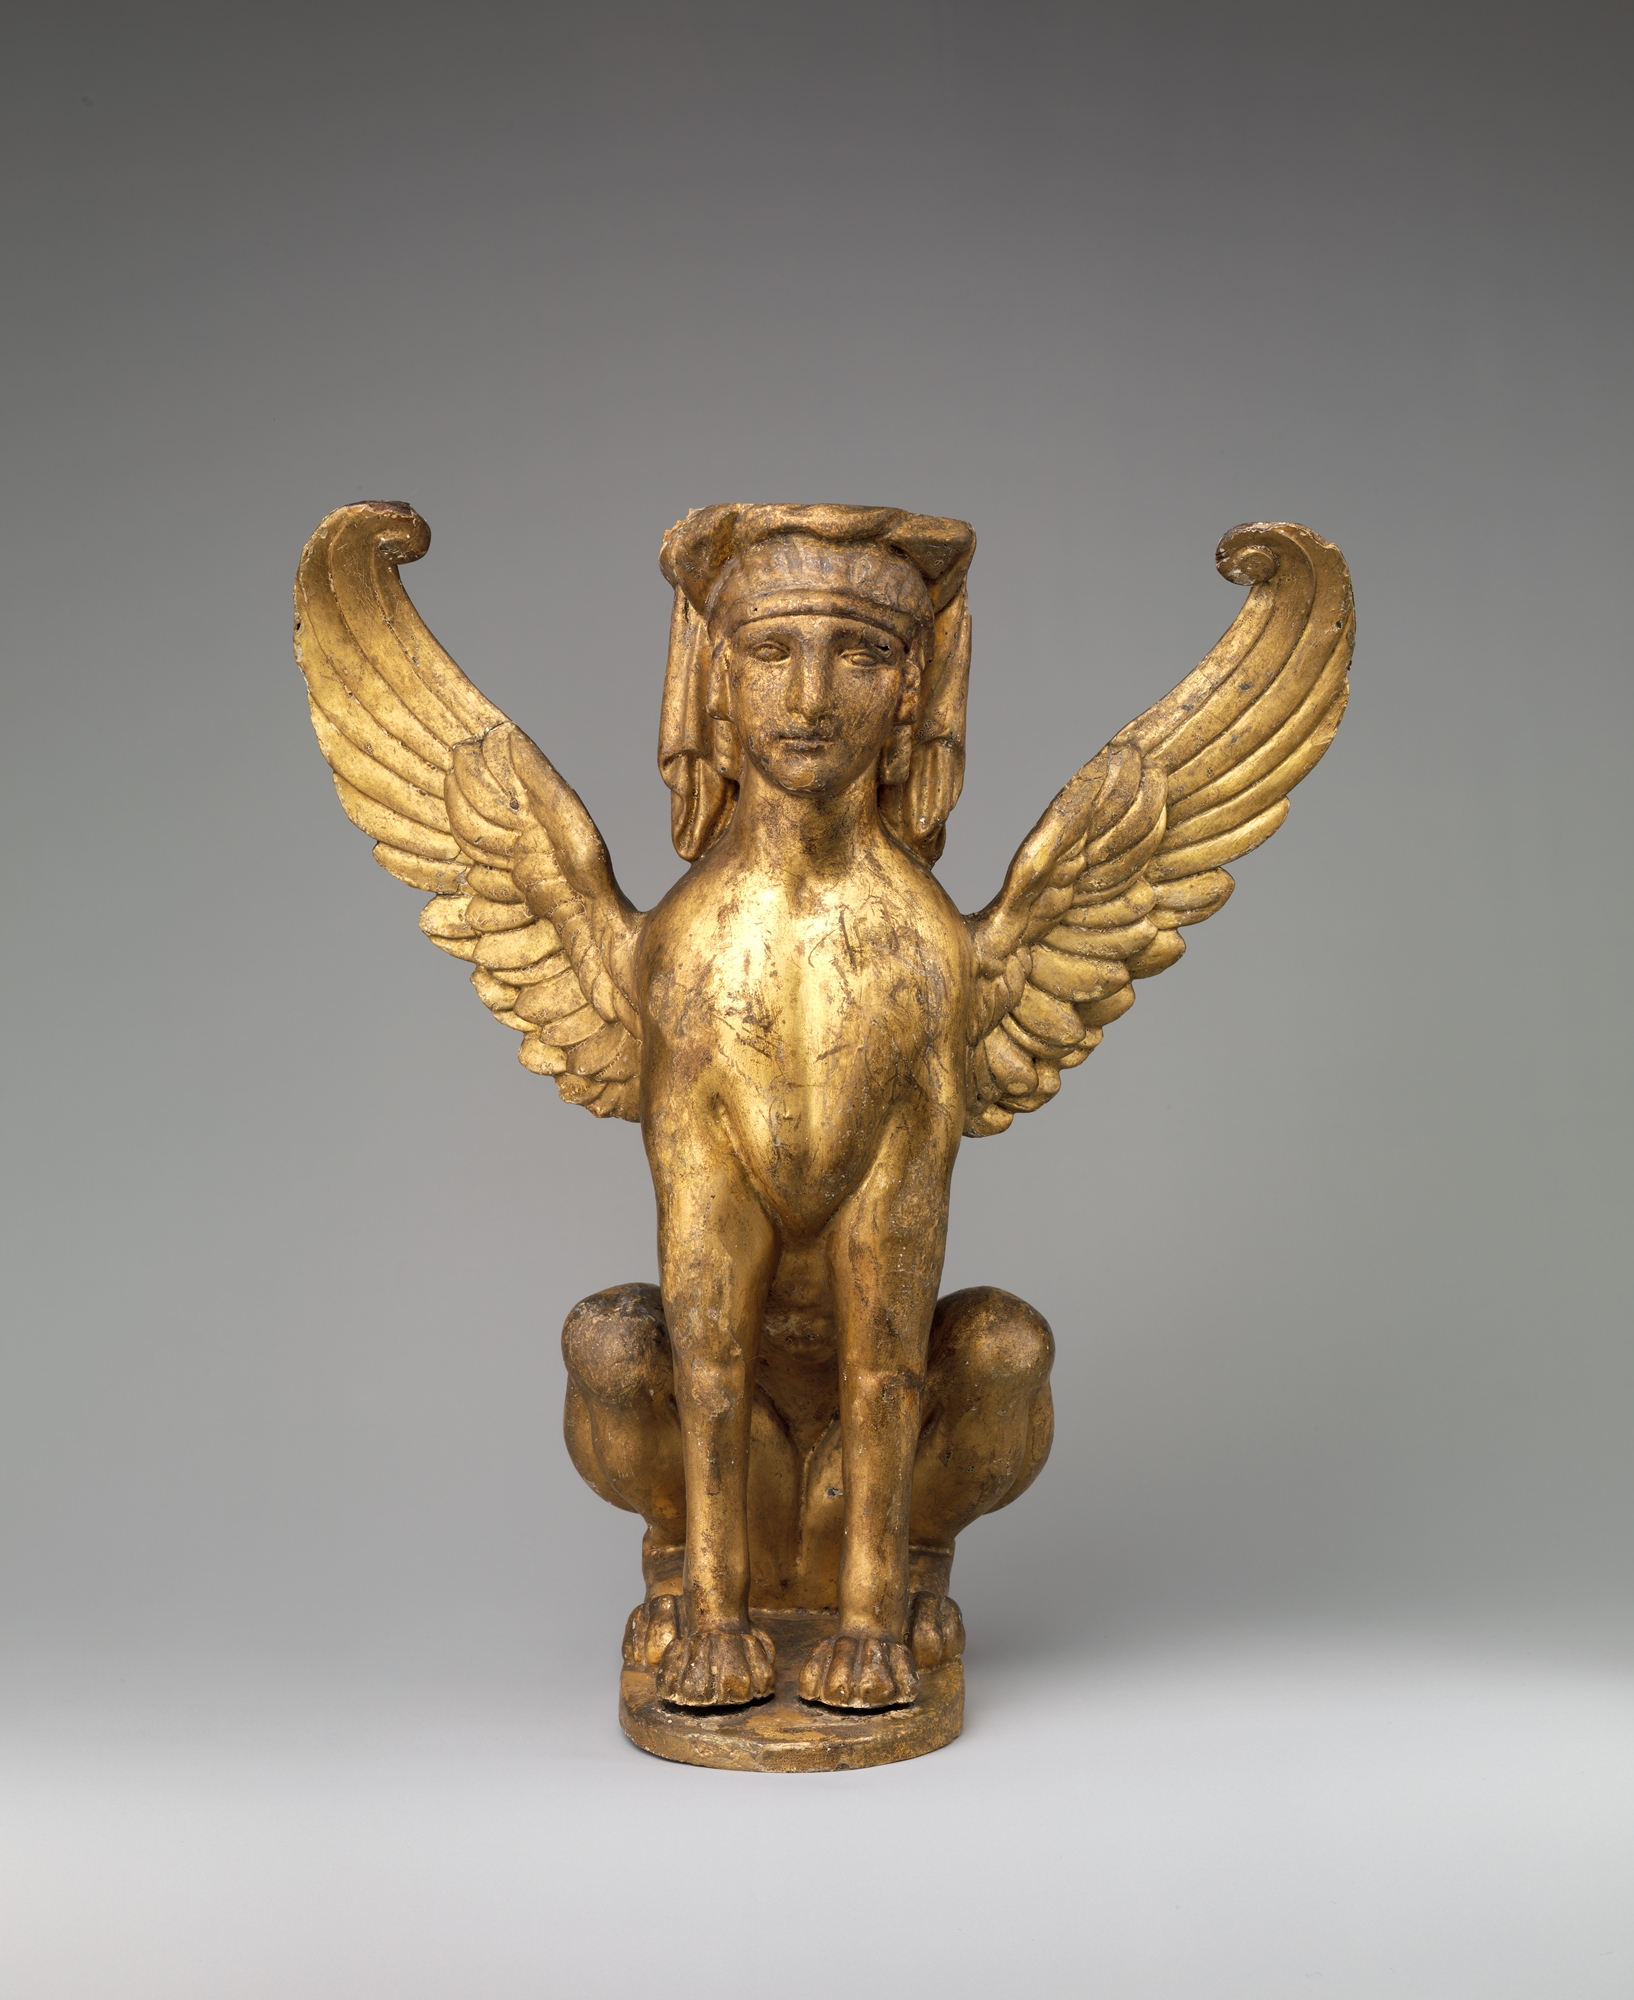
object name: figure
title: Winged sphinx (one of a pair)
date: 1767-1800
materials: wood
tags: sphinx